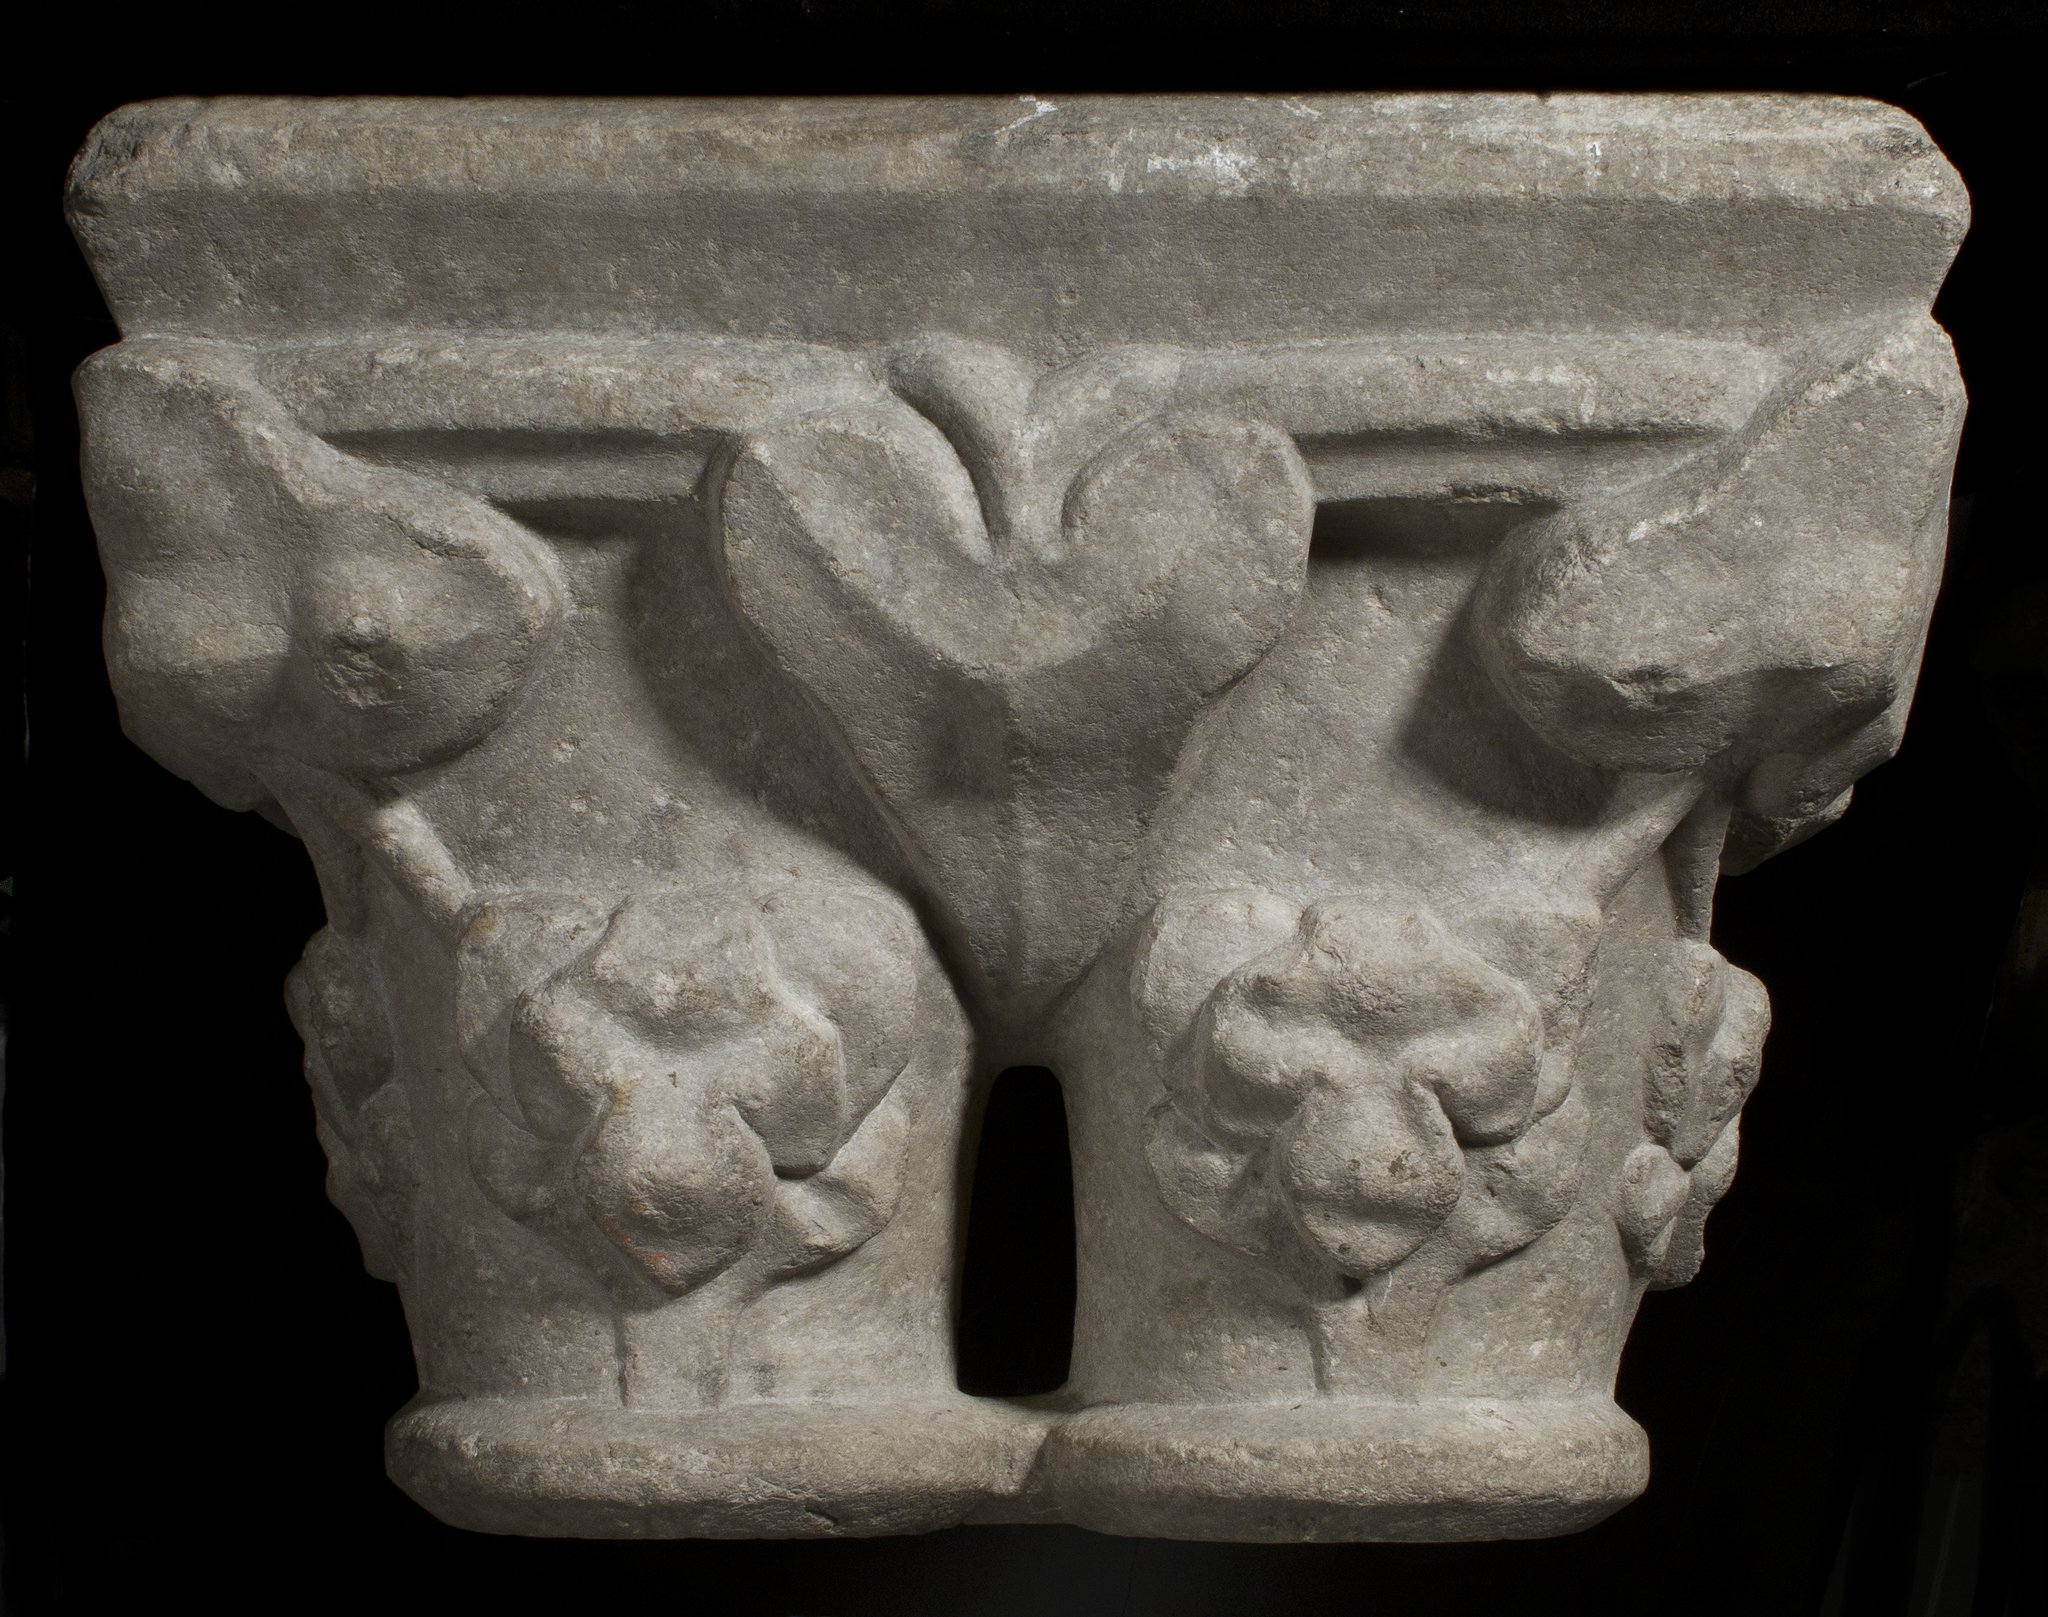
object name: capital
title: Double Capital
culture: french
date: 1267-1333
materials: marble